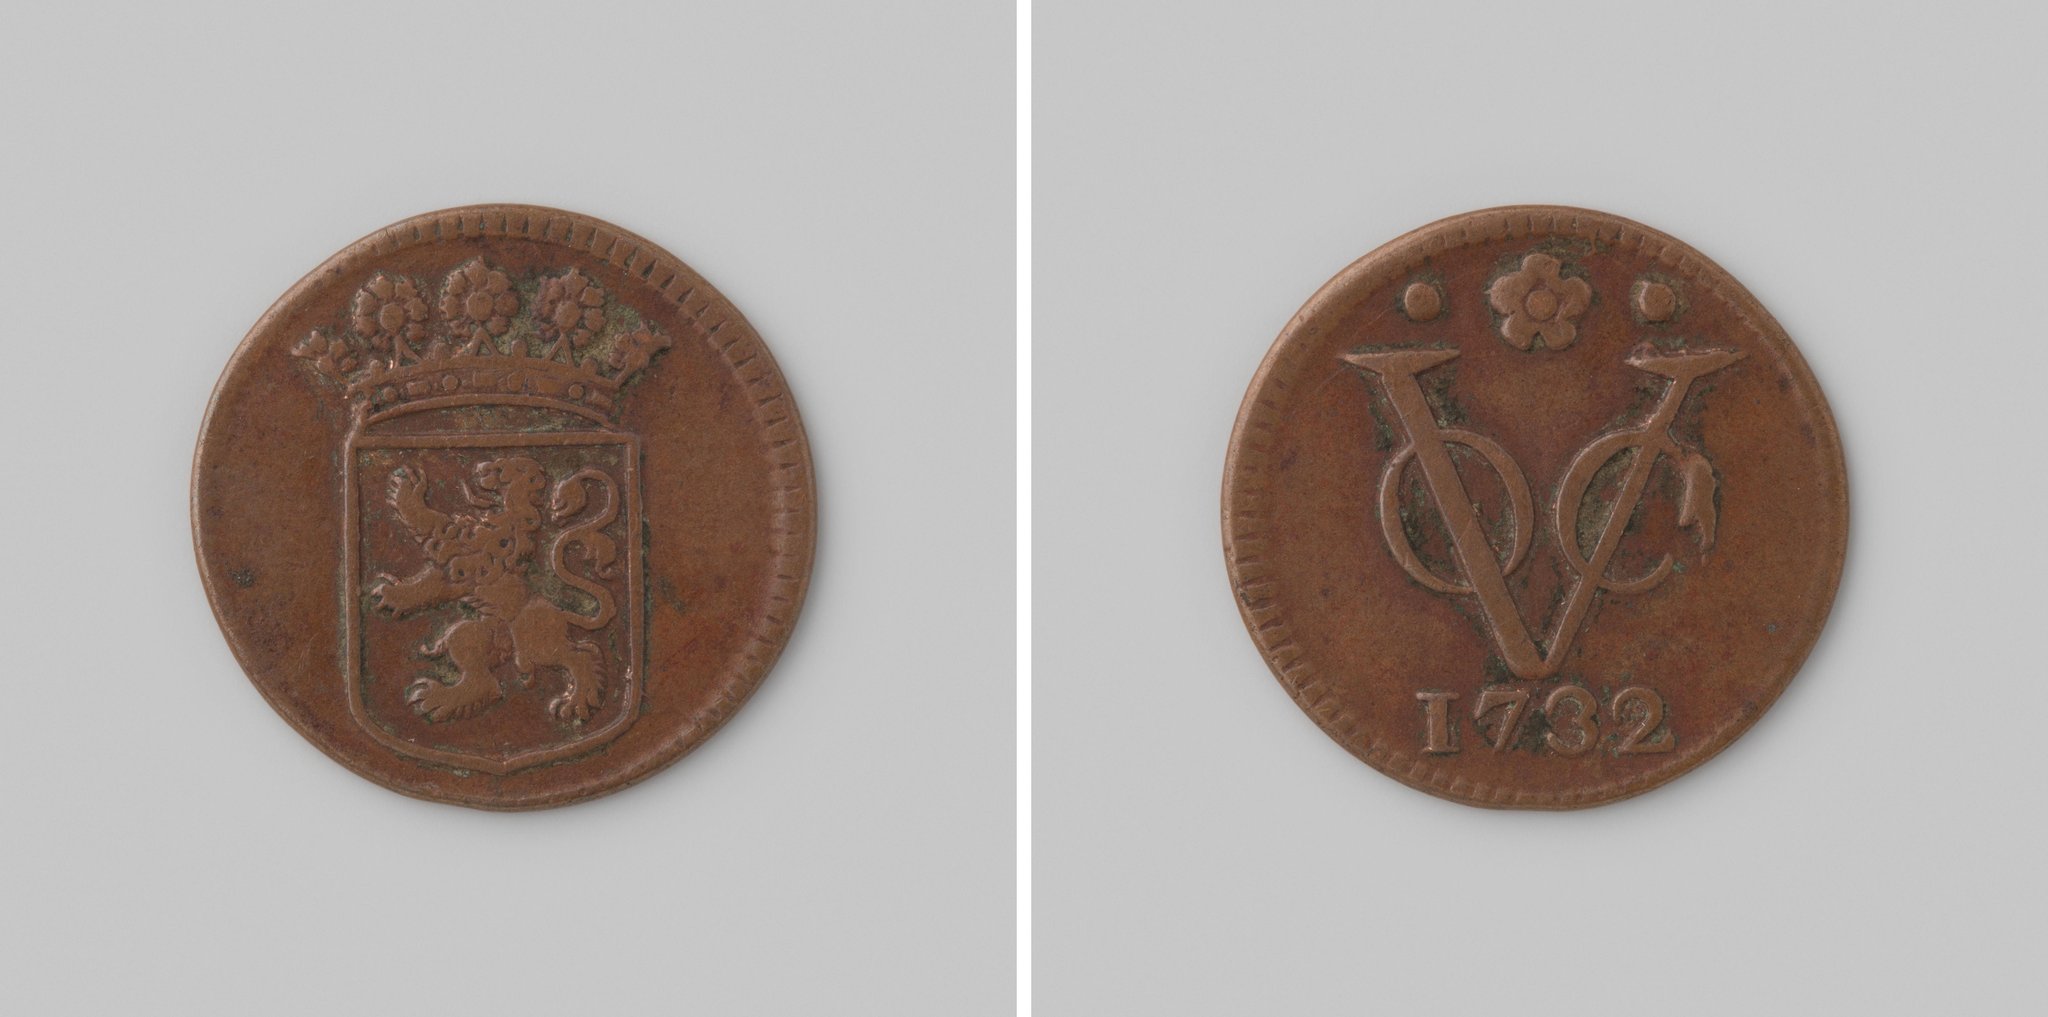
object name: coin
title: Koperen VOC-duit van Holland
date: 1732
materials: copper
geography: dordrecht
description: Voorzijde: gekroond provinciaal wapenschild. Keerzijde: VOC-beeldmerk, m.b. rozet en m.o. datering.